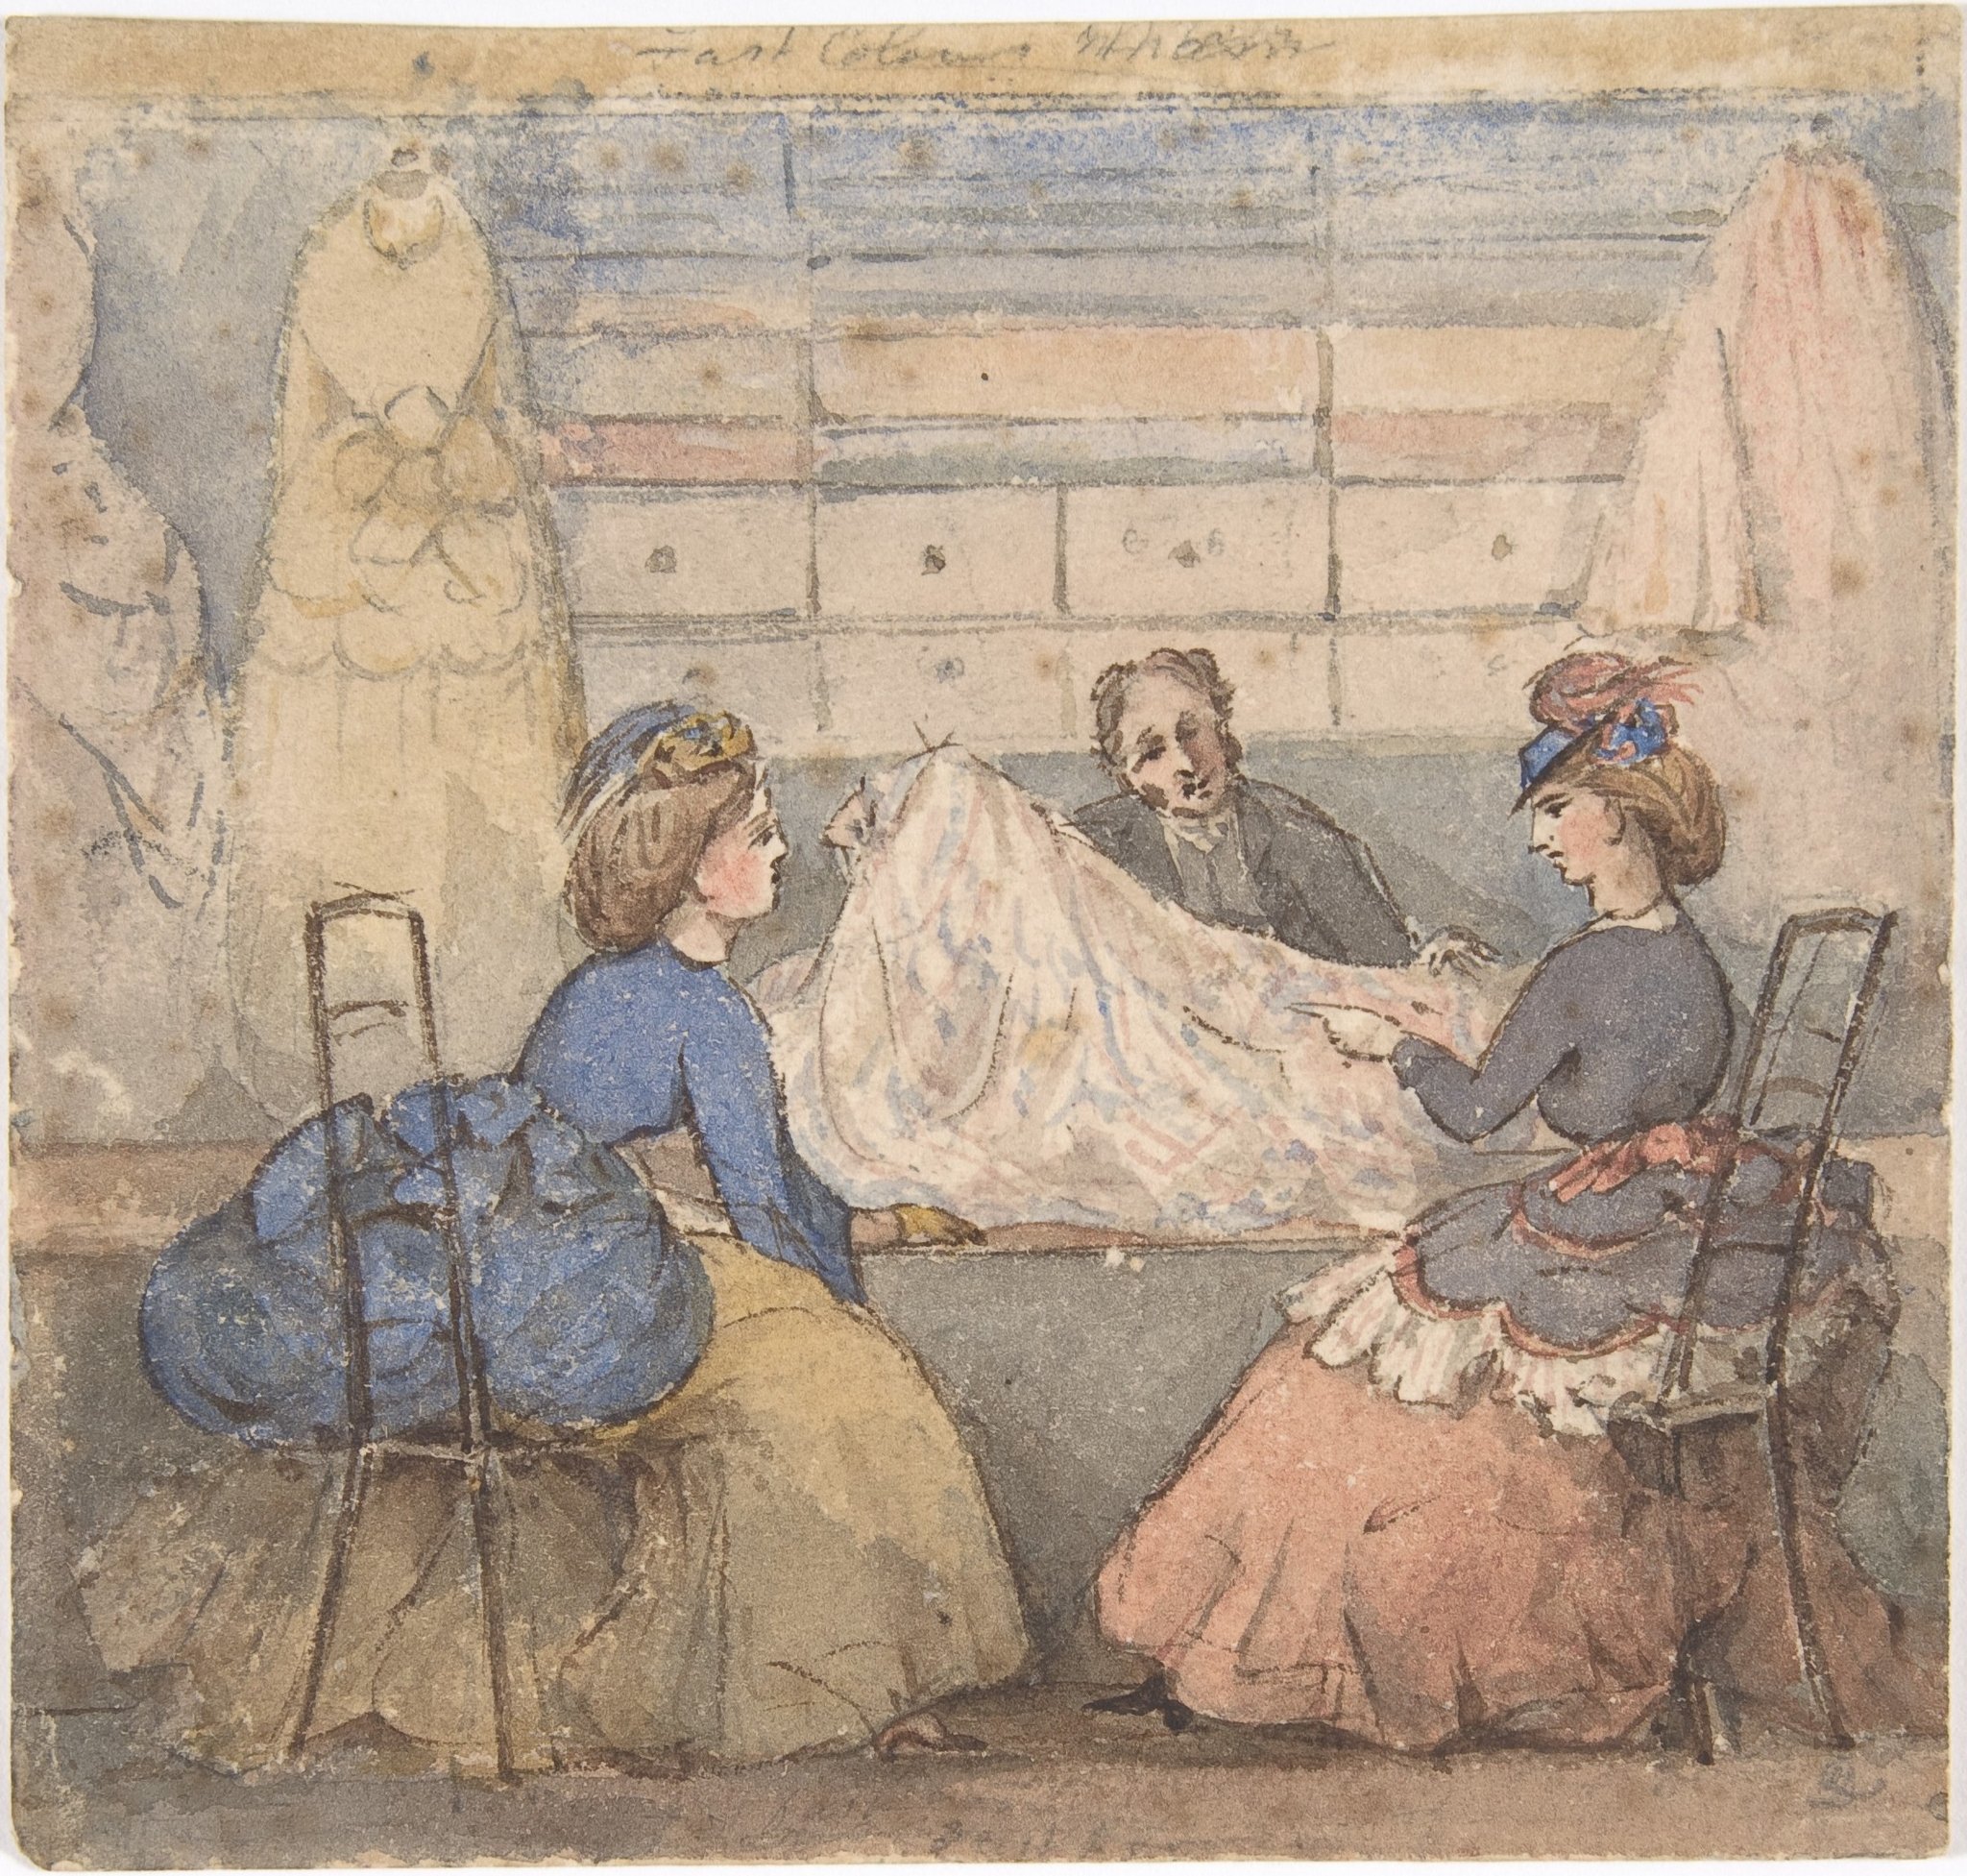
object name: drawing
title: Two Women Looking at Fabric in a Shop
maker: anonymous, british, 19th century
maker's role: artist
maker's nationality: british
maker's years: 1800-1900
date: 1801-1900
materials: watercolor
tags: women,shops